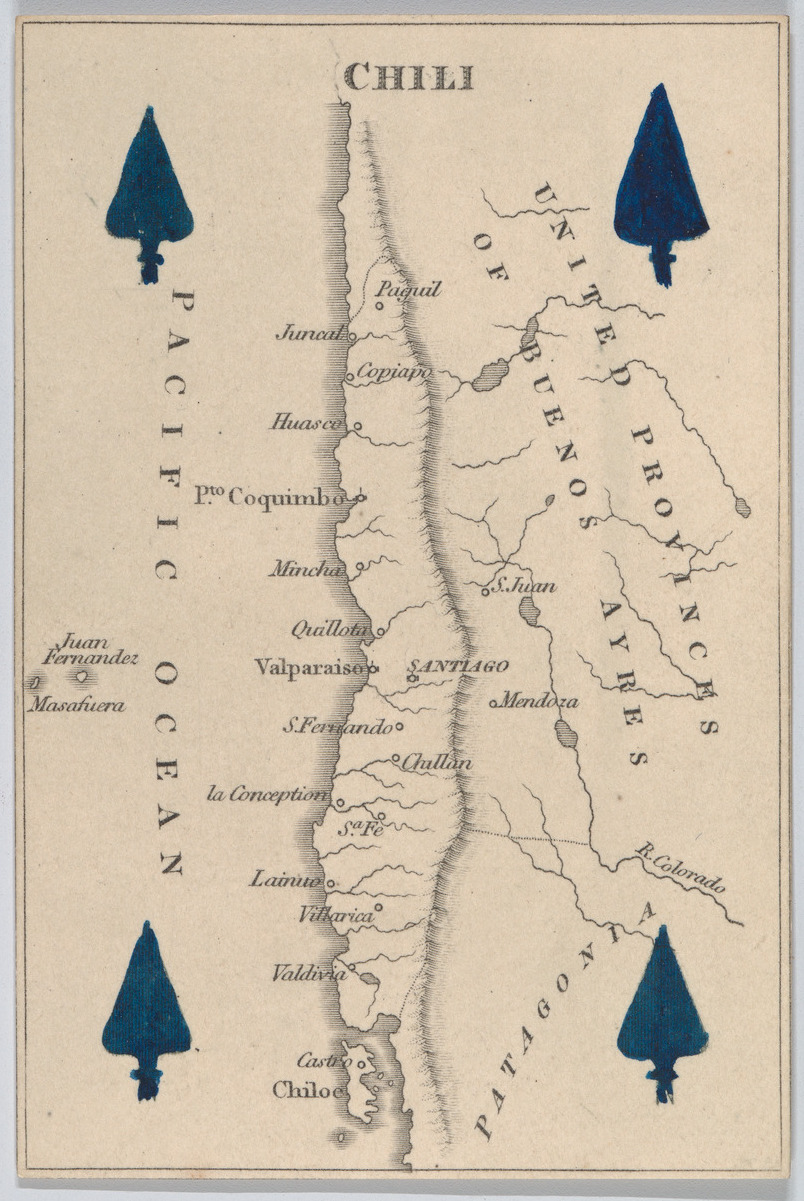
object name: print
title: Chili, from "Court Game of Geography"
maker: william and henry rock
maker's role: publisher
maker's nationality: british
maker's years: 1821-1884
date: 1838-1855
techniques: engraving, hand coloring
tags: playing cards,maps